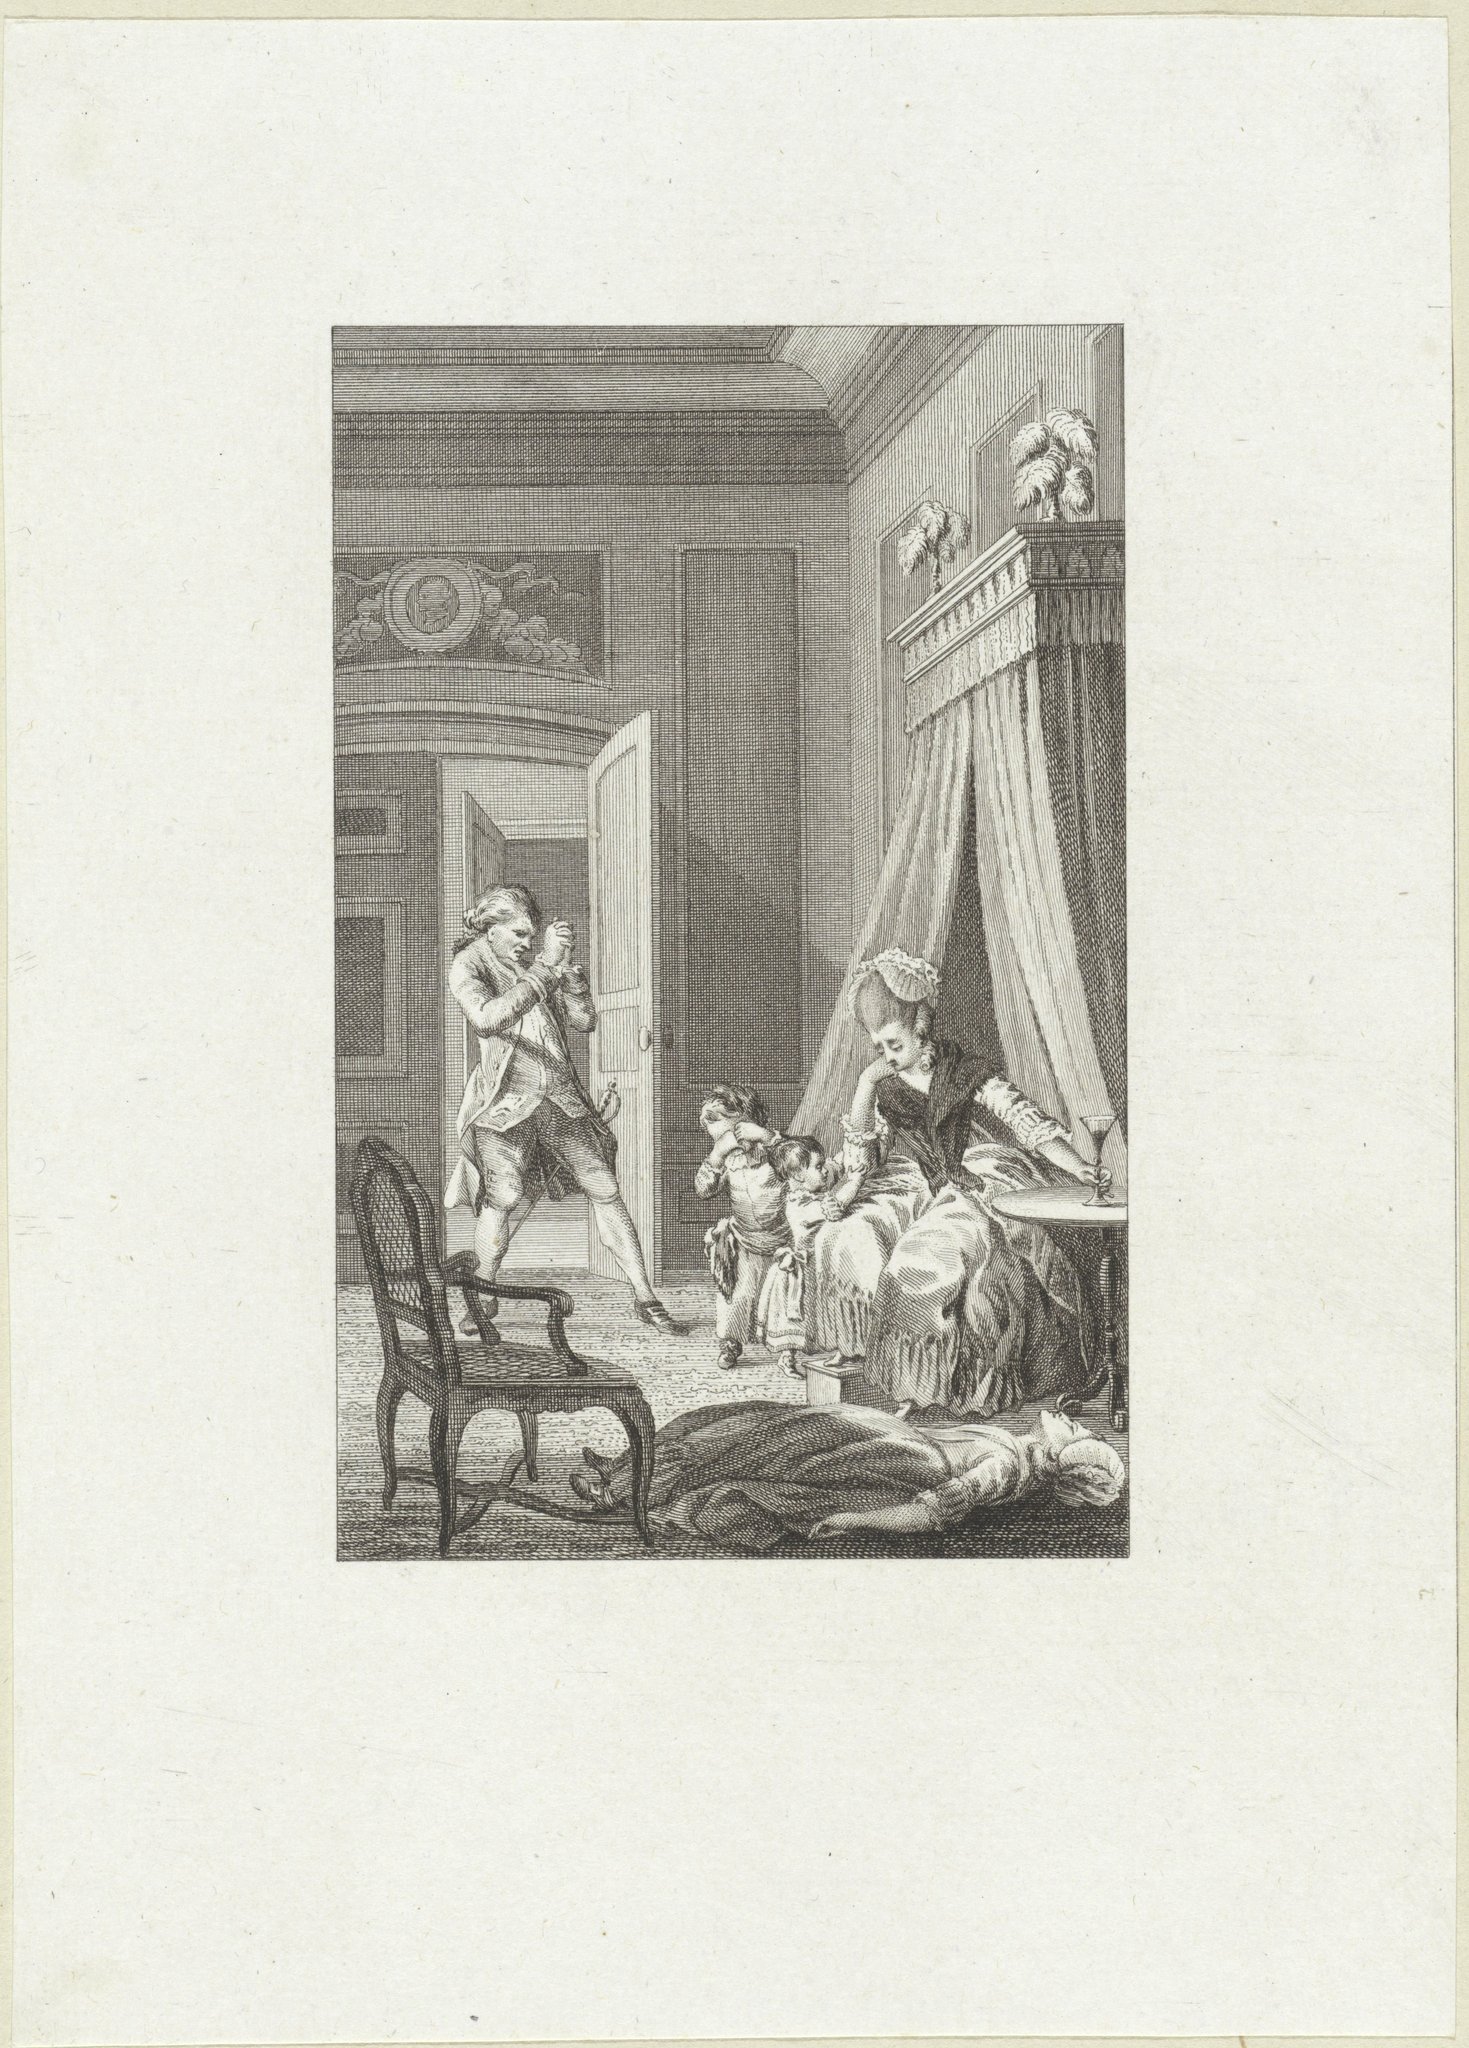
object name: print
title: Vrouw, man en twee kinderen bij een bewusteloze vrouw in een slaapkamer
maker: reinier vinkeles (i)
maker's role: draughtsman, print maker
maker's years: 1741-1816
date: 1781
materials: paper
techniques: engraving, etching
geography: amsterdam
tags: death of an adult person, weeping, one person praying, bedroom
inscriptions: collector's mark: Lugt 240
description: Proefdruk van een prent die ook gebruikt is als illustratie bij het verhaal 'Germeuil' voor: Baculard d'Arnaud, F.T.M. de. Zedelijke verhaalen, deel 6. Amsterdam: A. Mens Jansz., 1781.